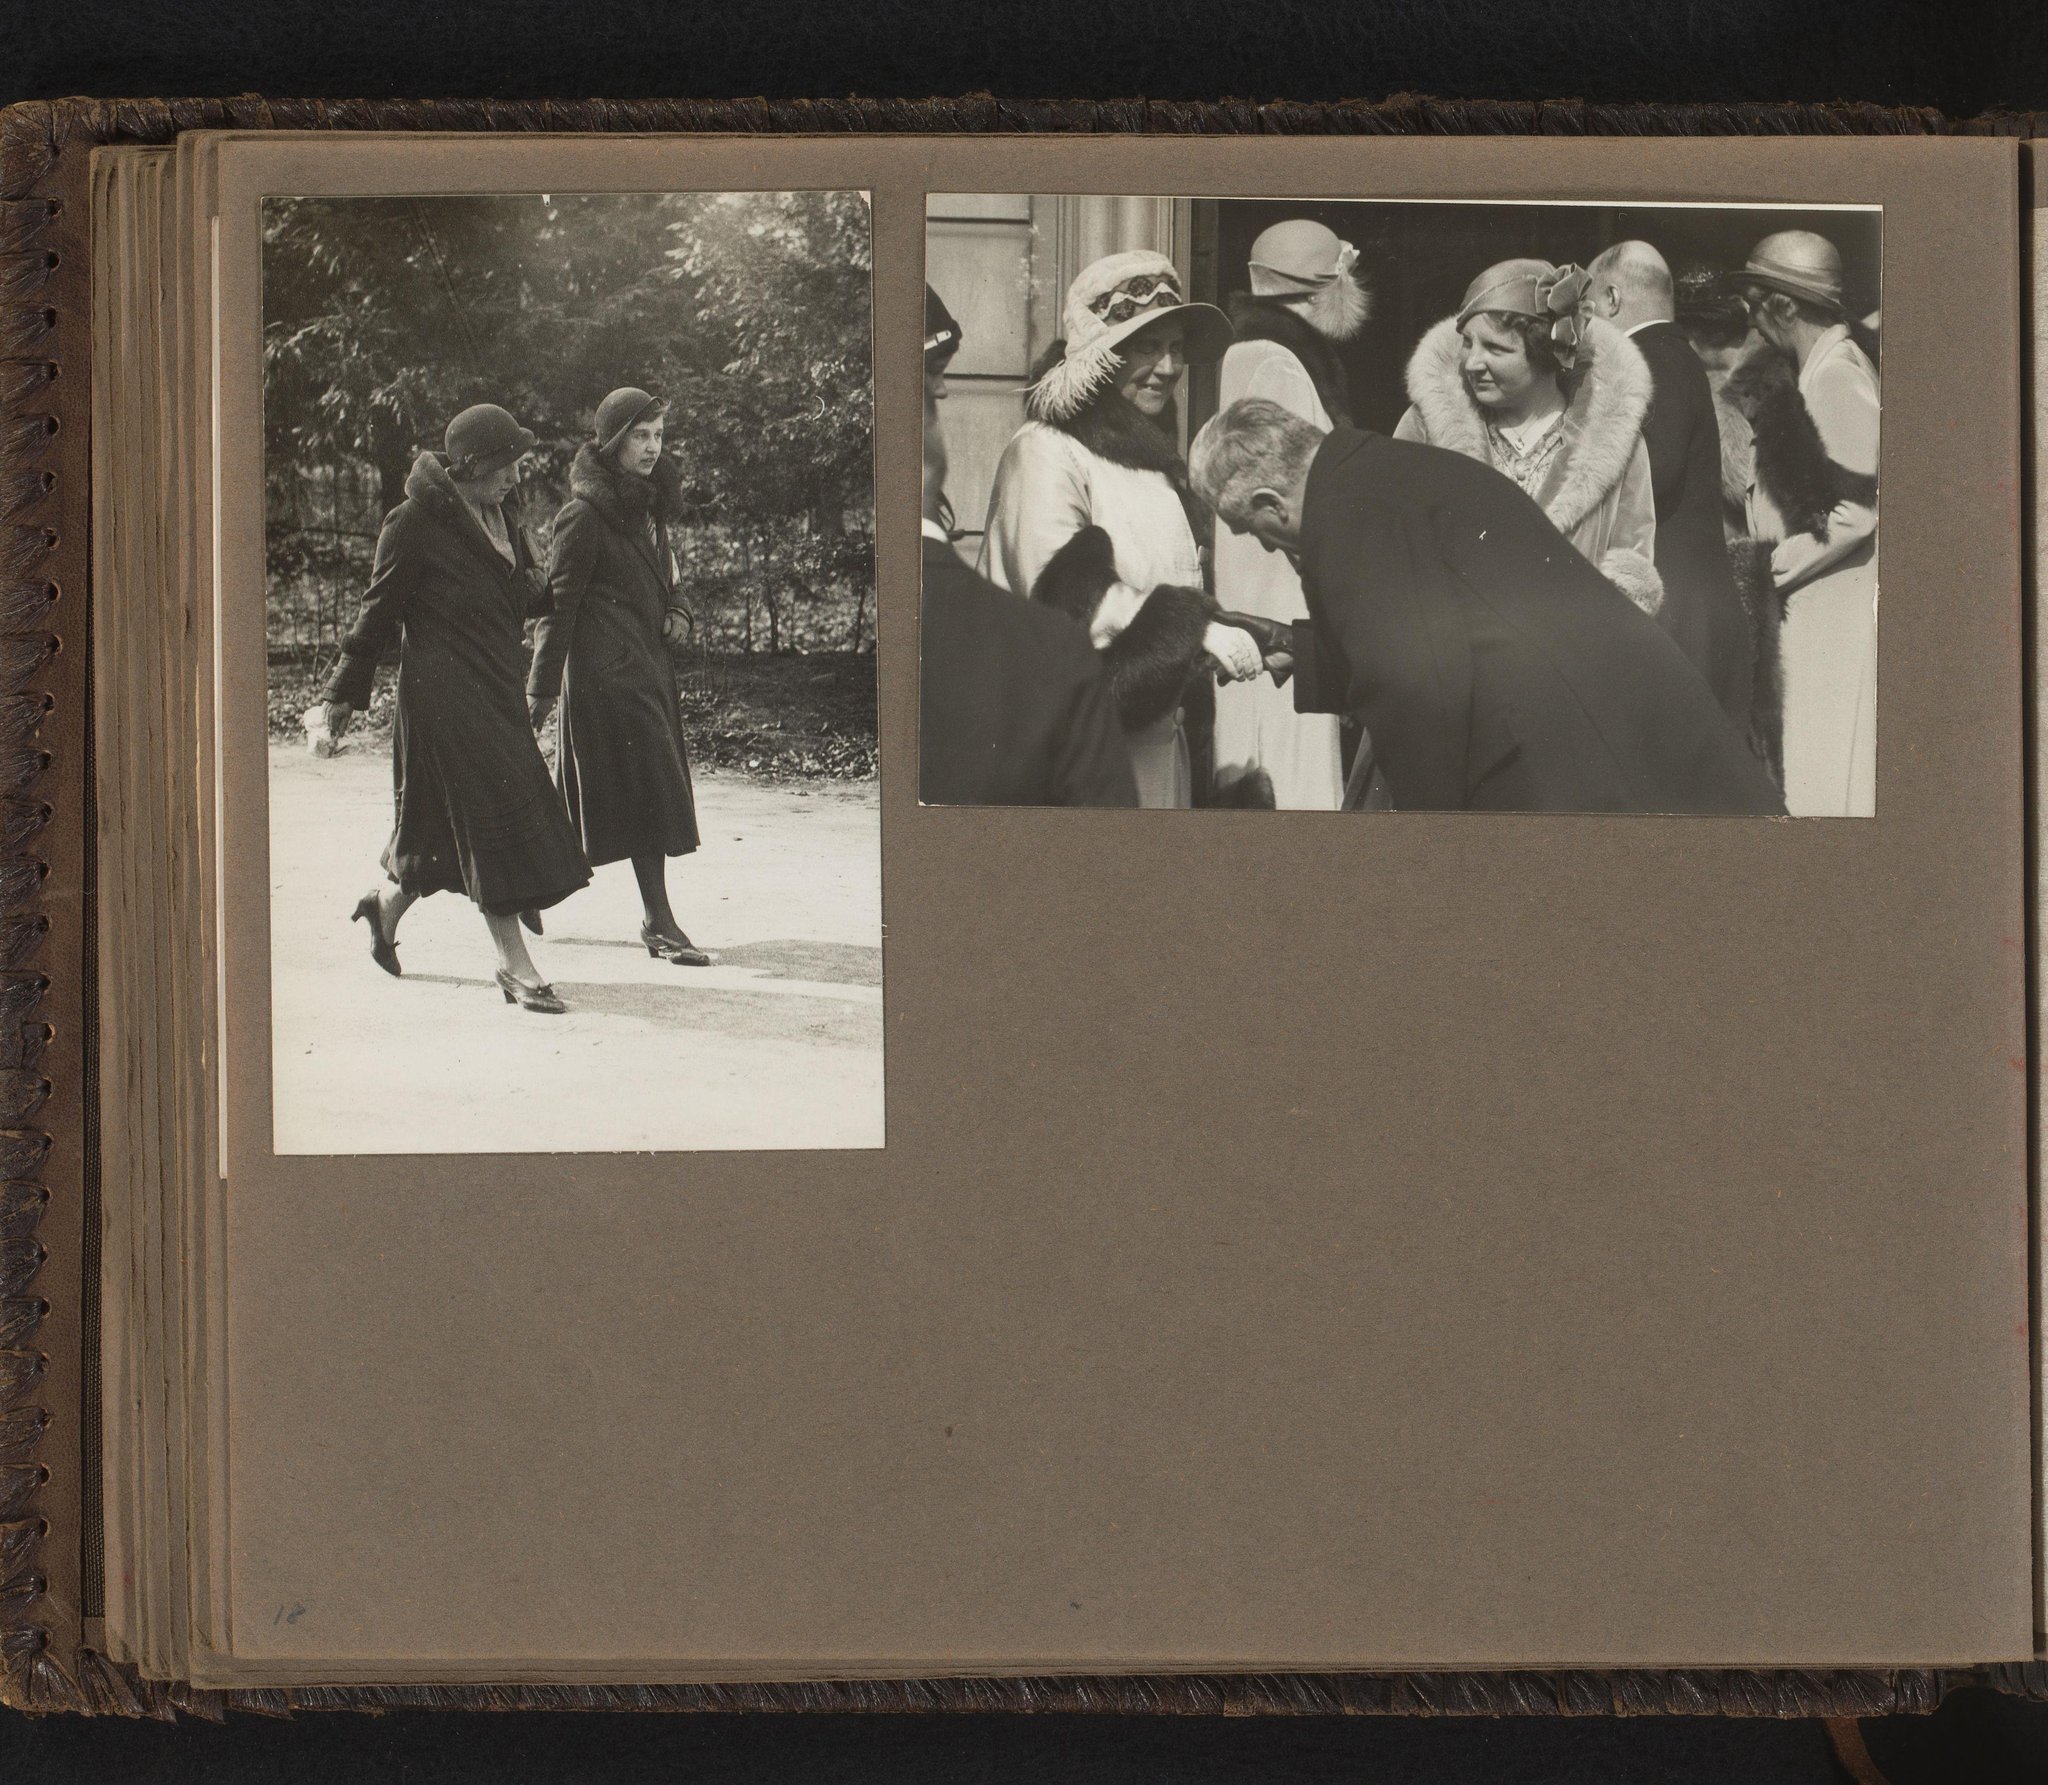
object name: album leaf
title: Twee foto's van prinses Juliana, wandelend en bij een bezoek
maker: Anonymous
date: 1930-1935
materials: paper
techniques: gelatin silver print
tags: the hague, juliana of the netherlands, adult woman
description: Deze foto's maken deel uit van een album.